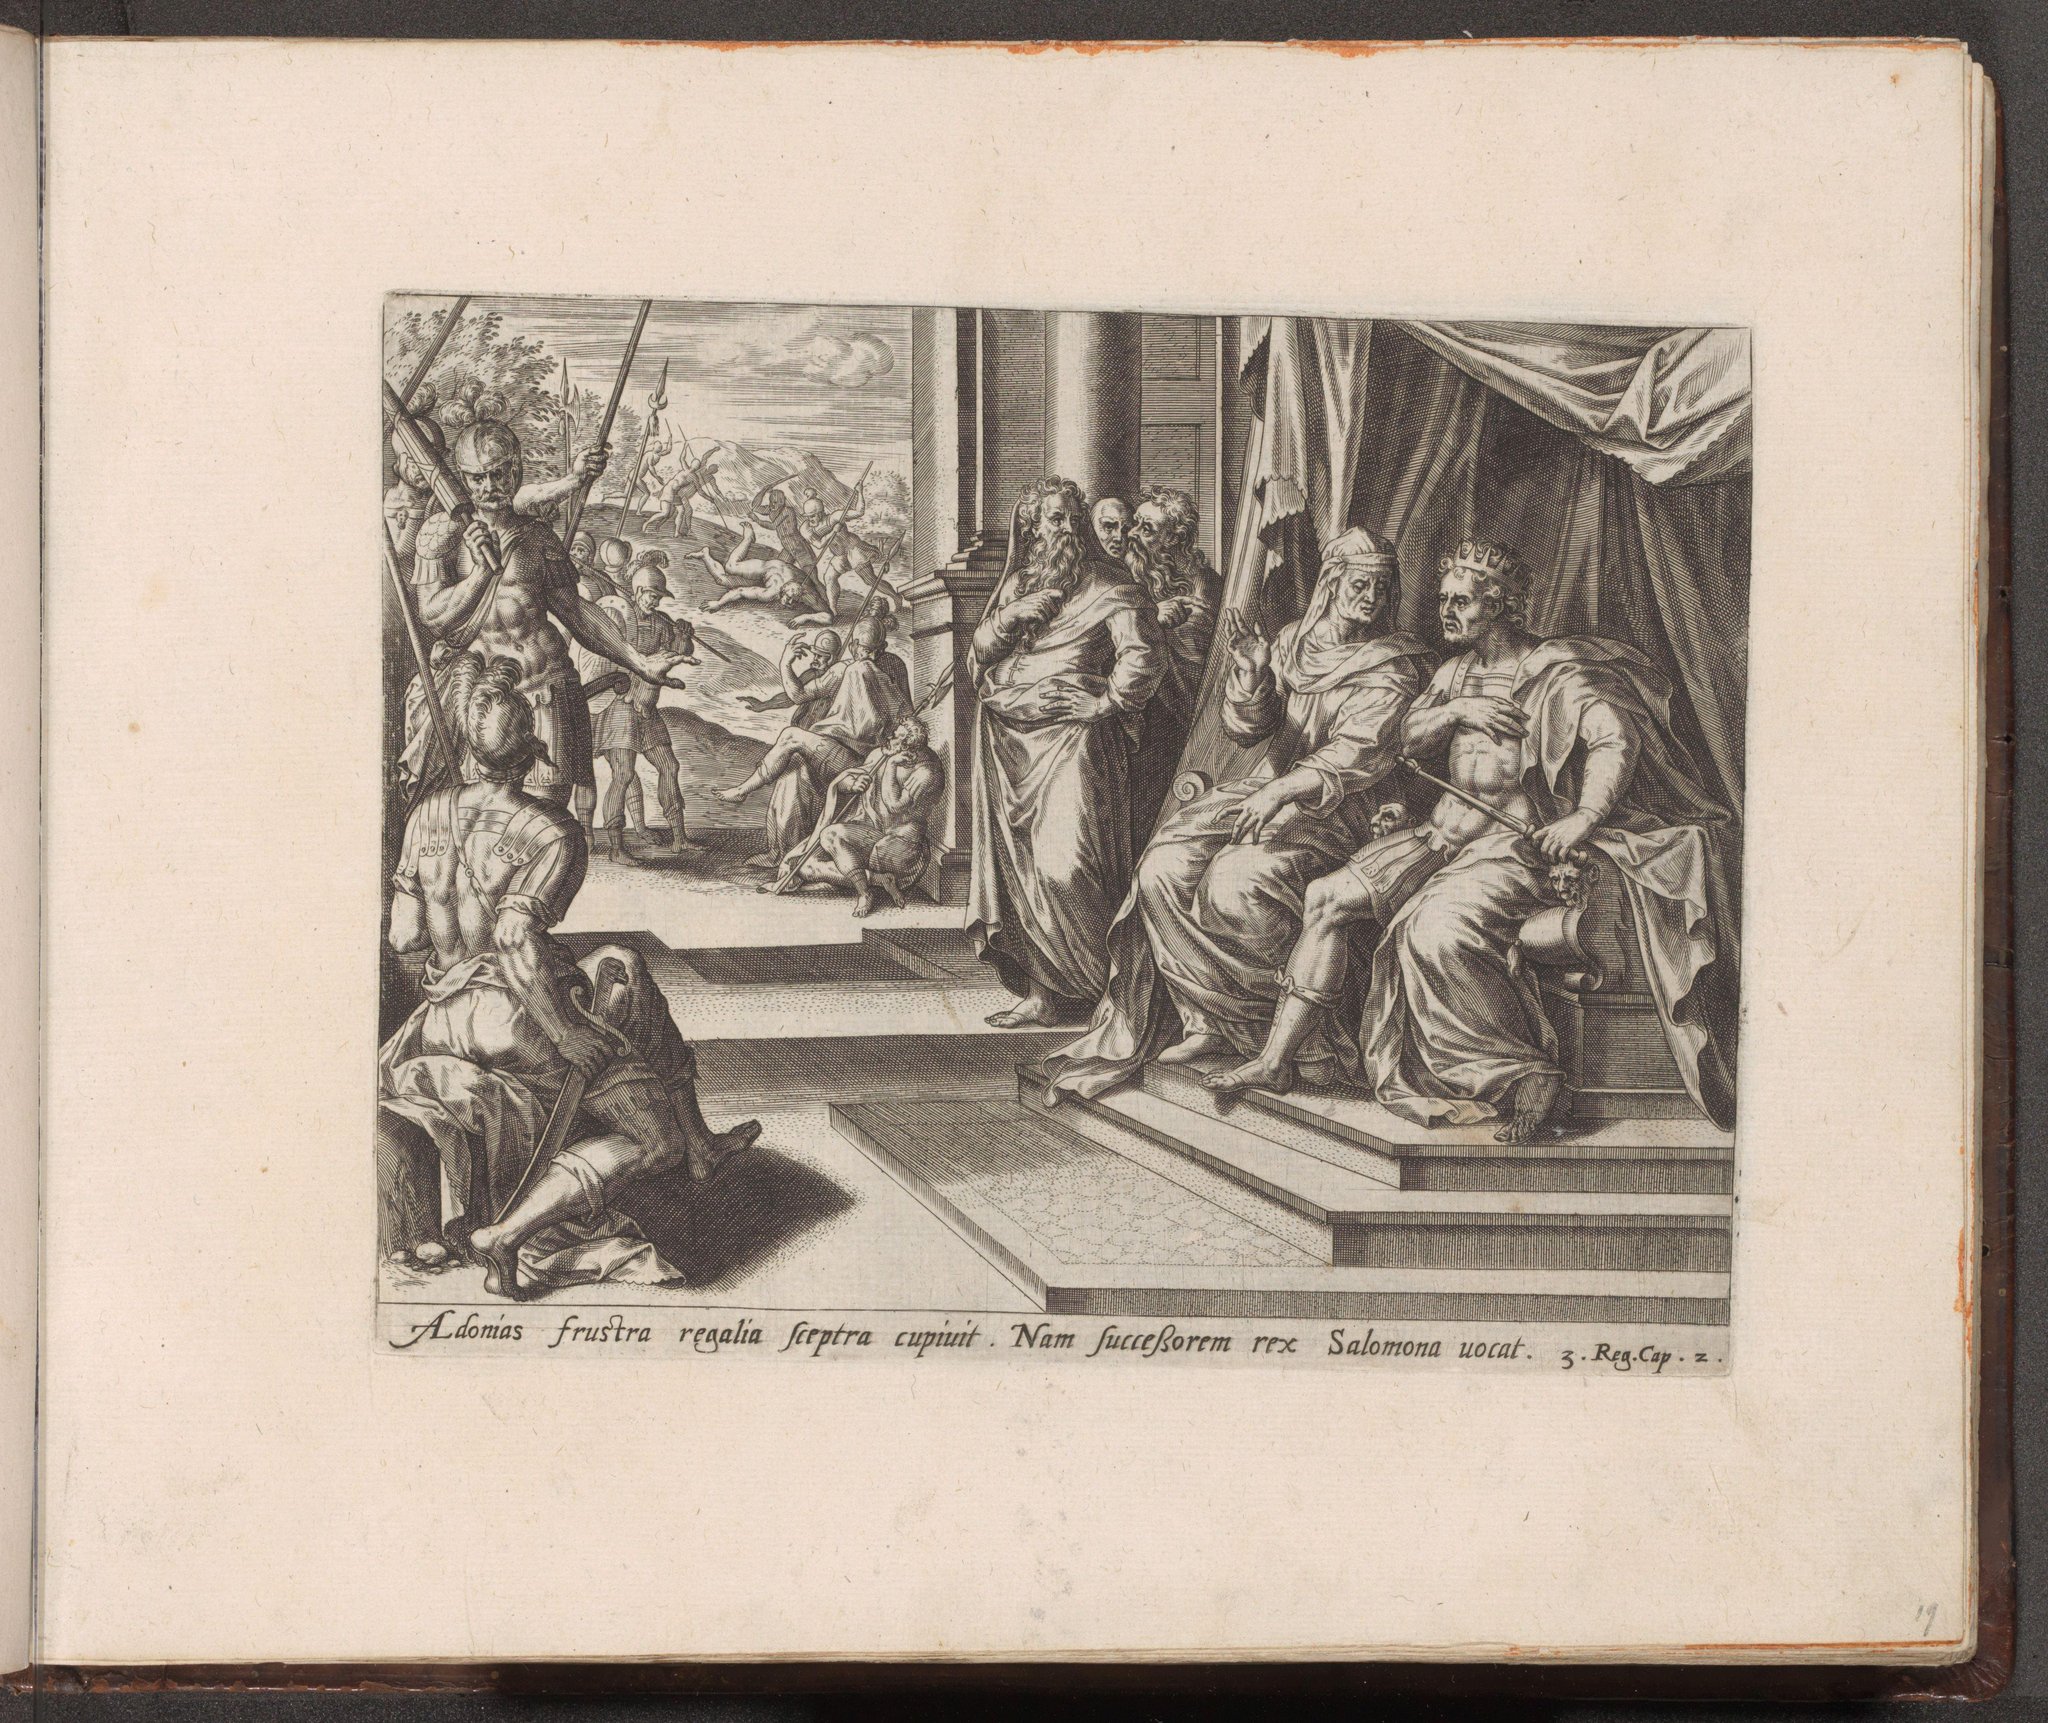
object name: album leaf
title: Historia Salomonis regis (...)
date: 1579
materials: paper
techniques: engraving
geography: antwerp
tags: bathsheba brings adoniah's request to solomon, adoniah is killed by benaiah, solomon and bathsheba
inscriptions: caption: ‘Adonias frustra regalia...Salomona vocat. 3 Reg. Cap. 2’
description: Batseba zit aan de rechterhand van haar zoon, koning Salomo, en brengt de vraag van Salomo's broer Adonia aan hem over. Zij vraagt voor Adonia om de hand van Abisag. Salomo wordt woedend en geeft opdracht Adonia te doden. Op de achtergrond wordt Adonia met een lans doorstoken. Onder de voorstelling een verwijzing in het Latijn naar de Bijbeltekst in 1 Kon. 2. Prent maakt deel uit van een album.